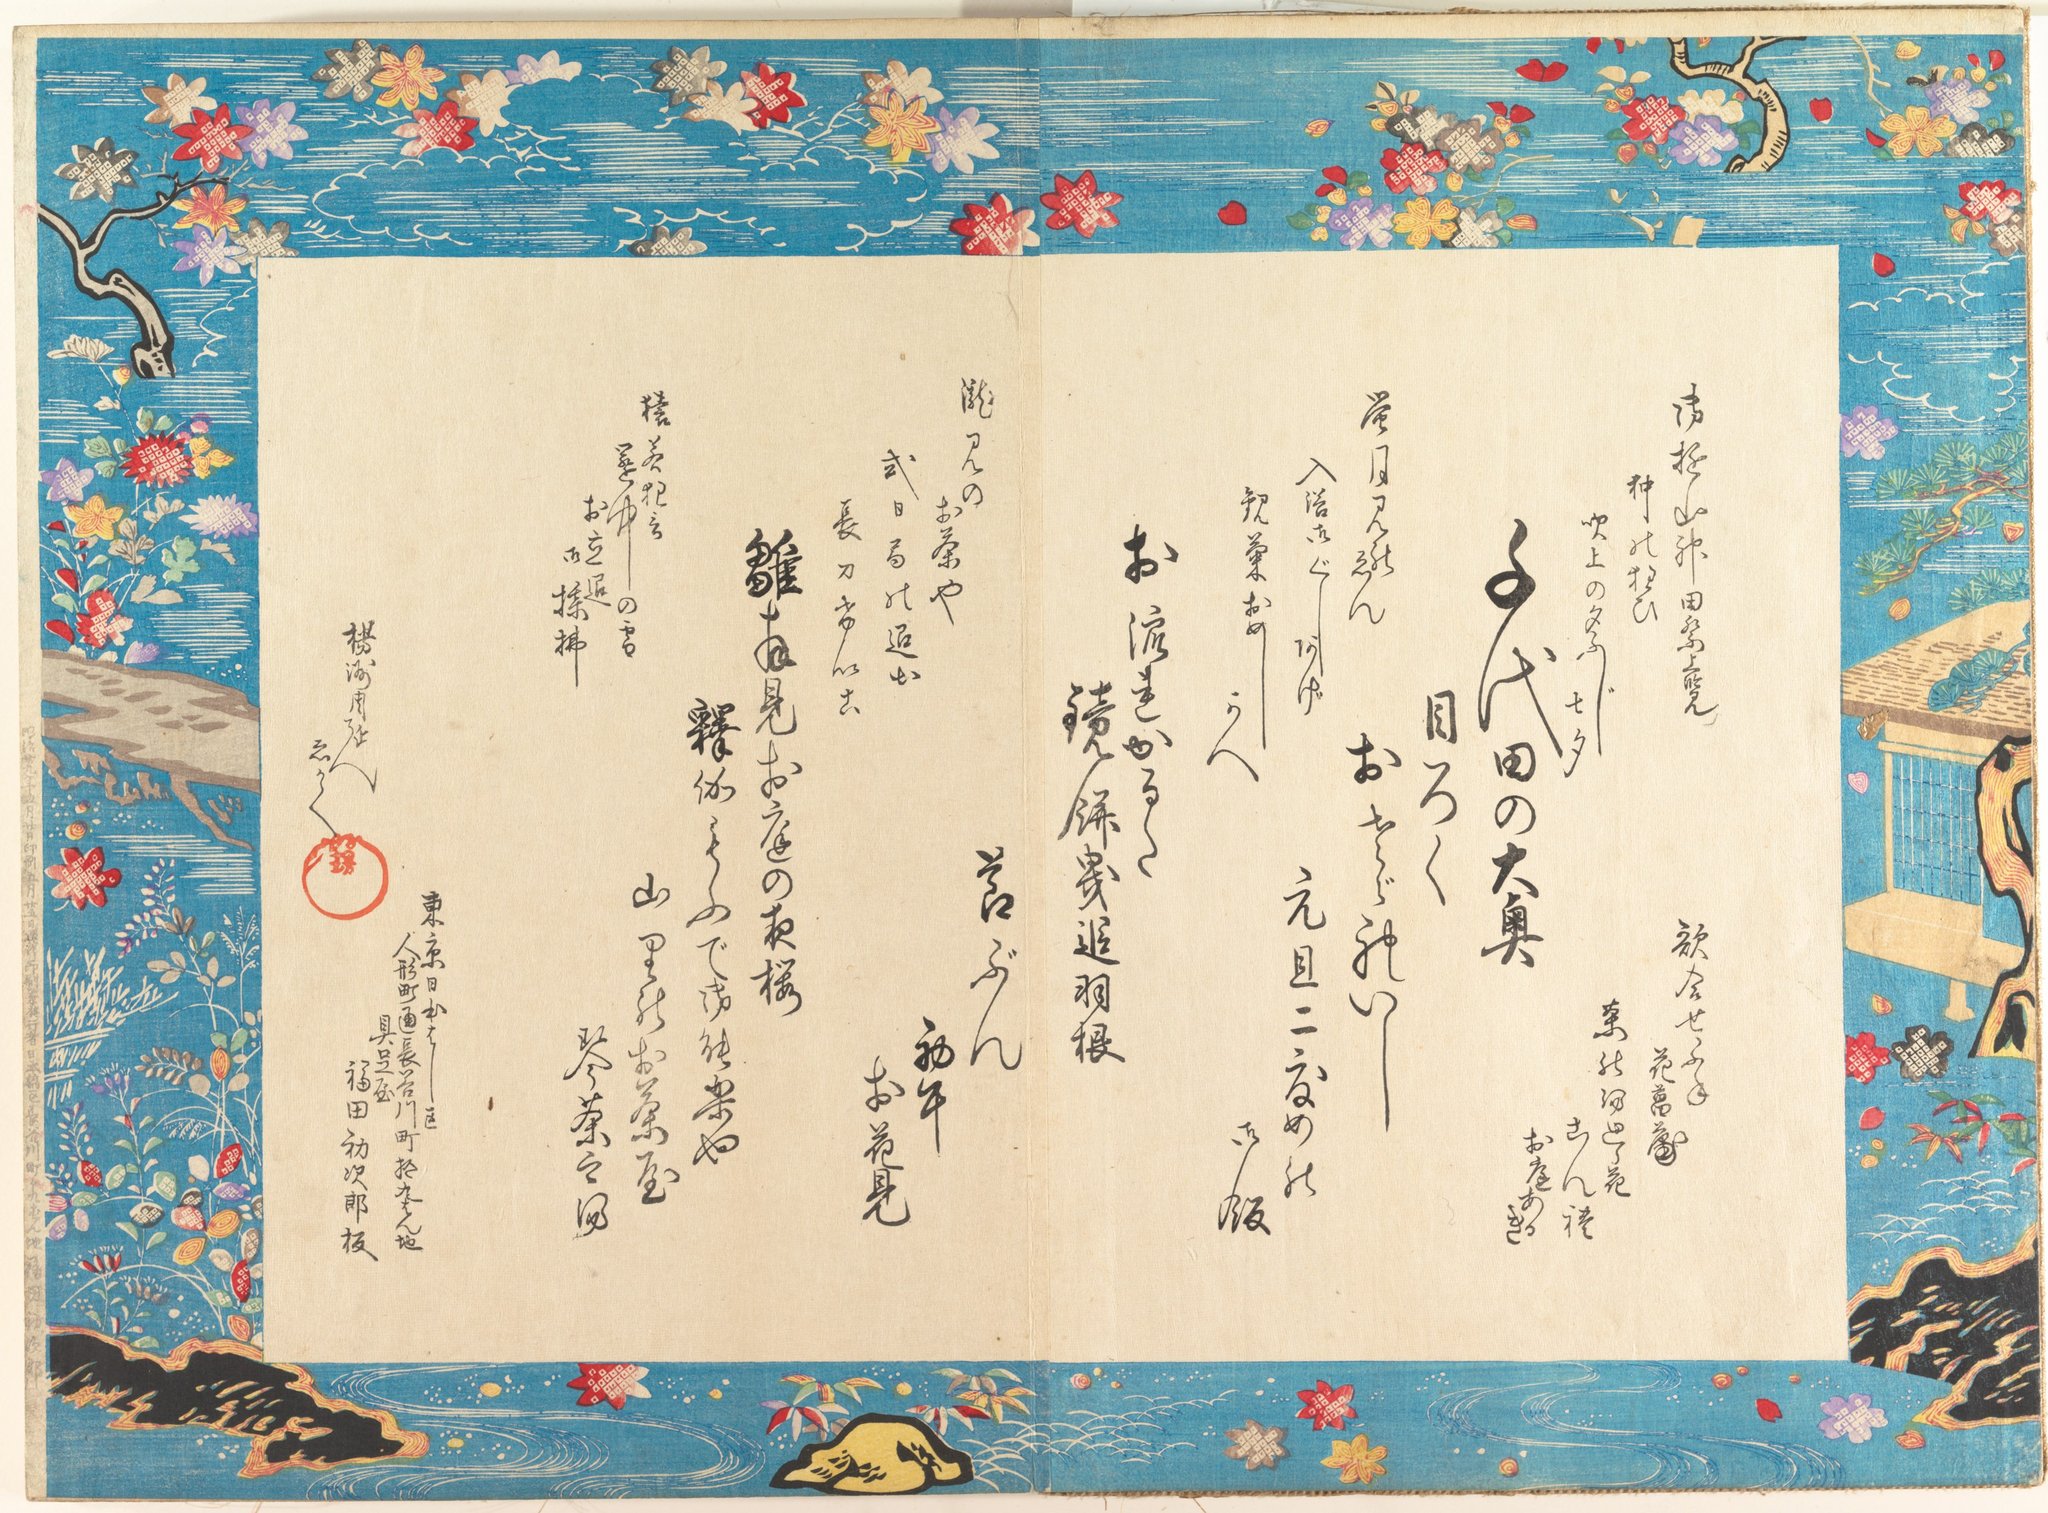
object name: print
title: The Inner Palace of Chiyoda (Chiyoda no Ōoku)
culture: japanese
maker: yōshū (hashimoto) chikanobu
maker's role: artist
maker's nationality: japanese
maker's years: 1838-1912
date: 1895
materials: ink, paper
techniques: woodblock print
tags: flowers